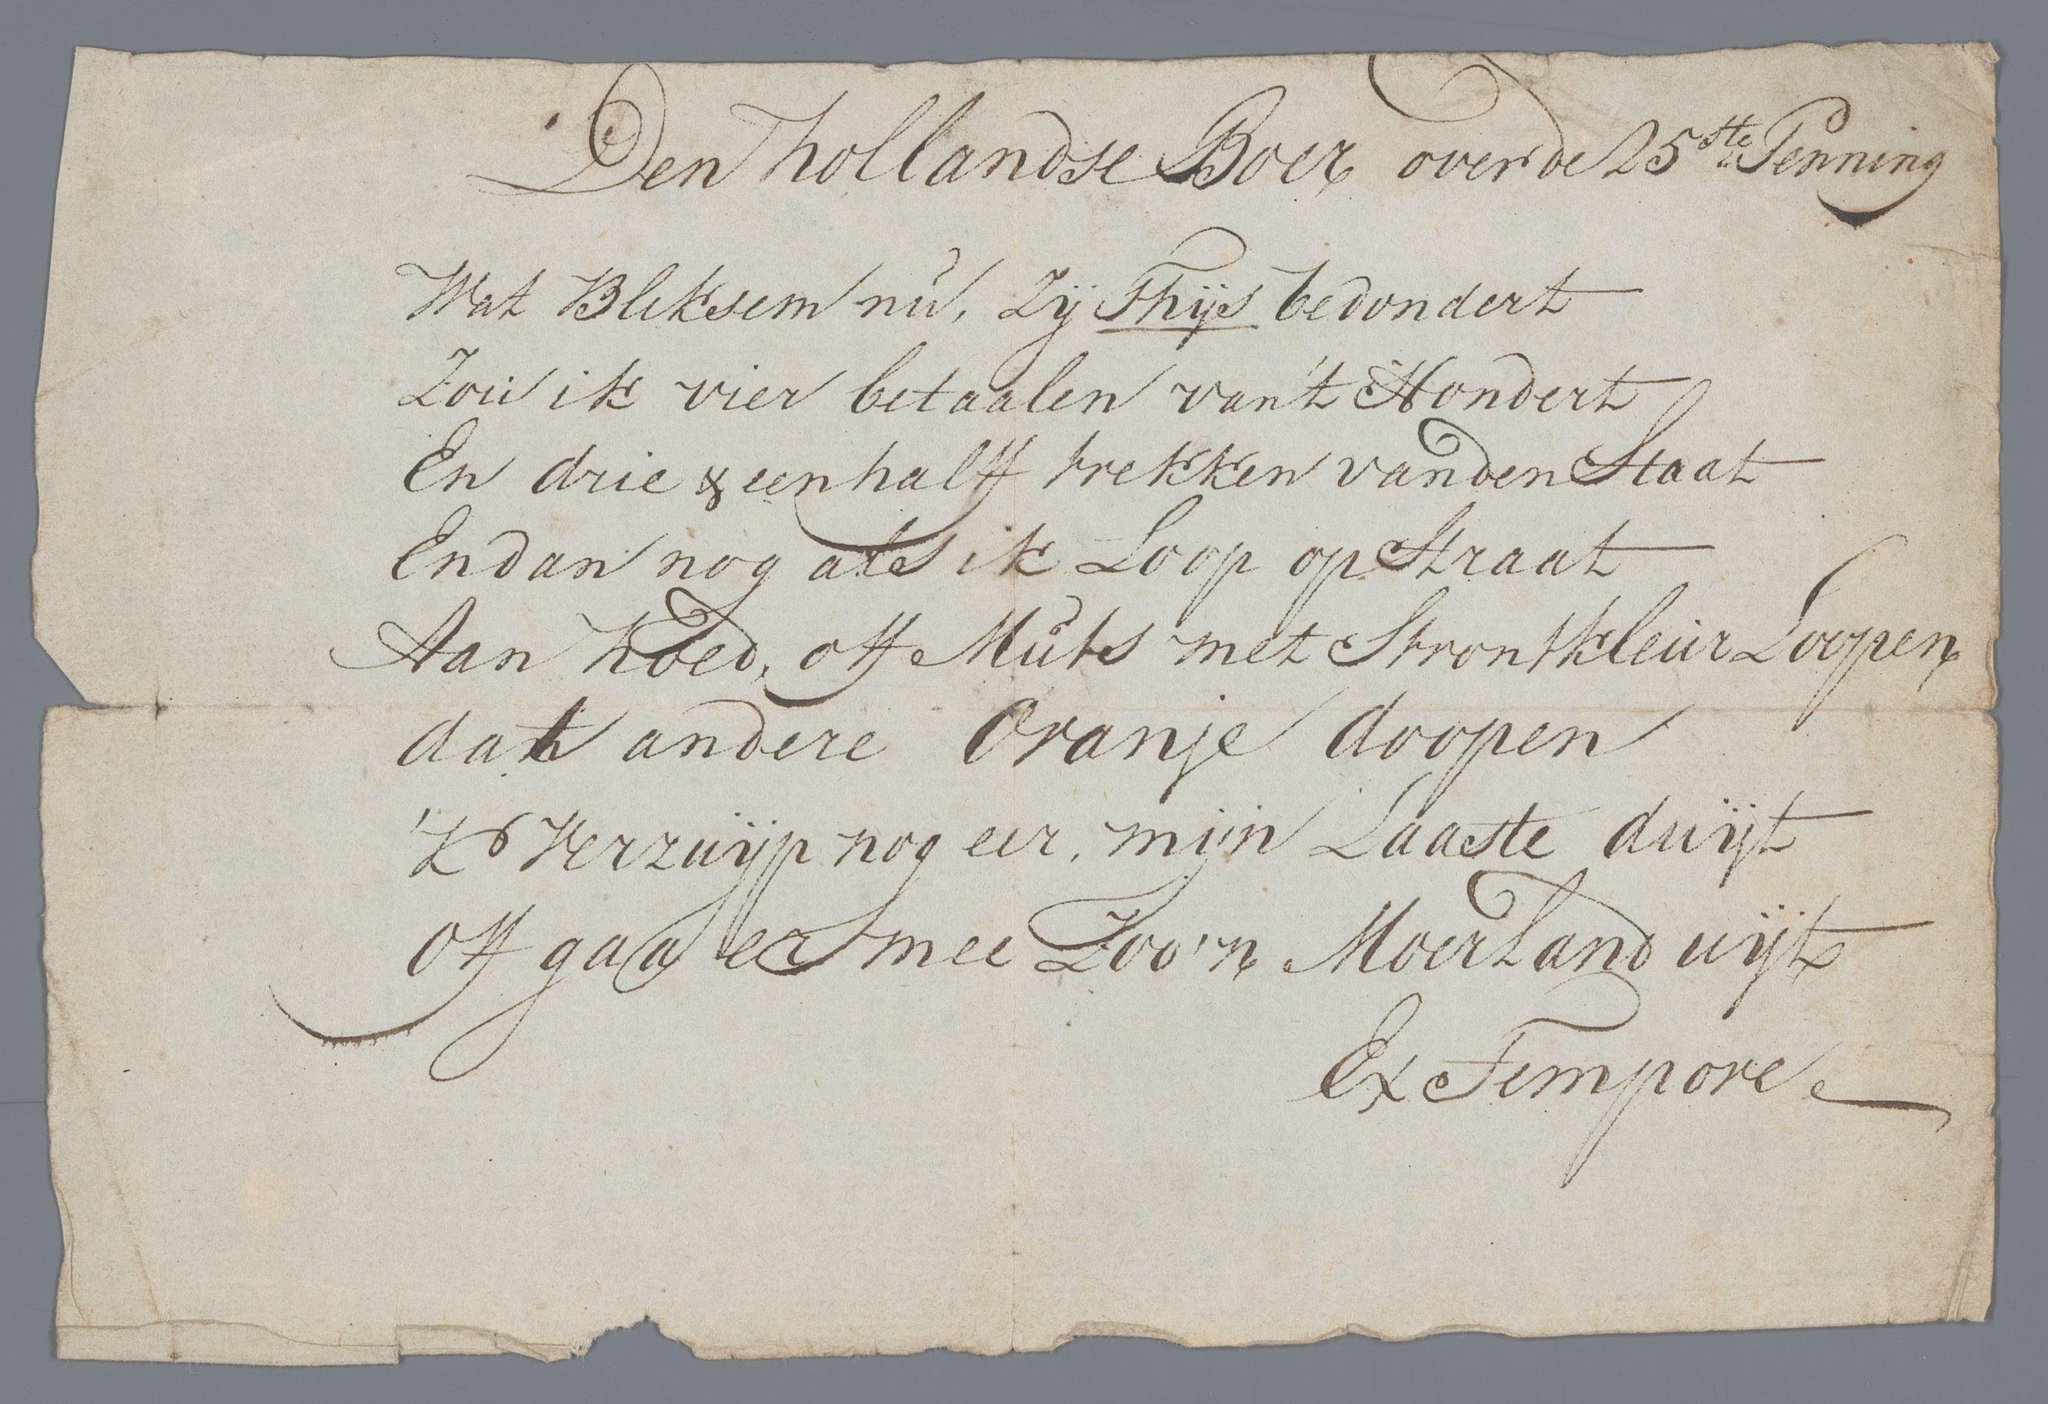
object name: poem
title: Den hollandse Boer over de 25ste penning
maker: Anonymous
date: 1775-1800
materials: ink, paper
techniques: writing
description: Op blauw-achtig papier geschreven gedicht van acht regels: "Wat Bliksem.......Ex Tempore". Schimpdicht op de 25ste Penning en het Huis van Oranje.